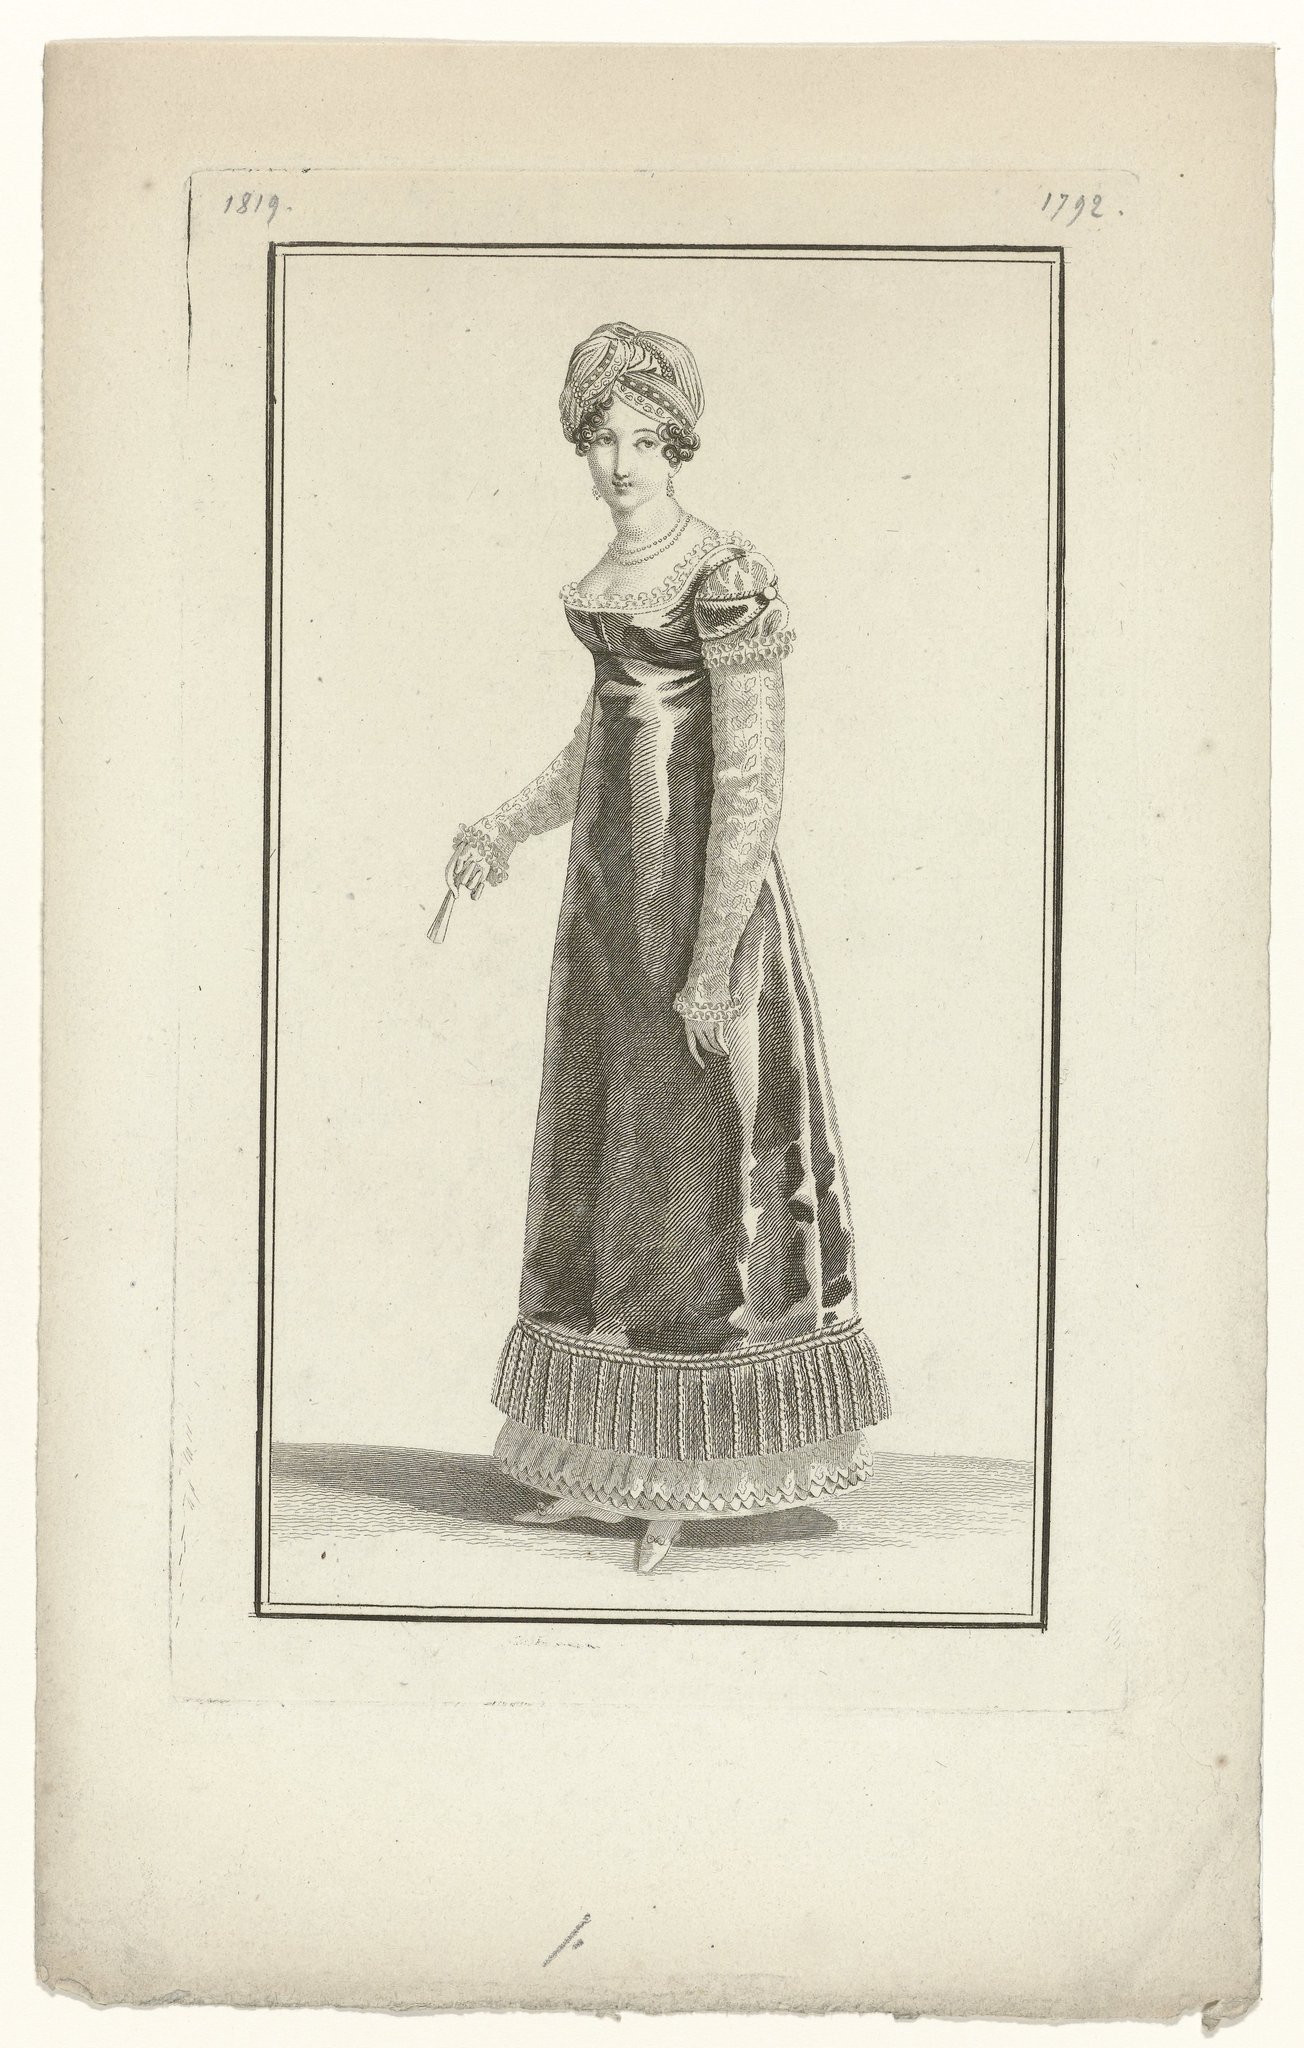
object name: fashion print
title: Journal des Dames et des Modes, Costume Parisien, 5 février 1819 (1792)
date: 1819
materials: paper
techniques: engraving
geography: paris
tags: ear-rings (+ women's clothes), head-gear: turban (+ women's clothes), dress, gown (pardessus) (+ women's clothes), fashion plates, shoes, sandals (+ women's clothes), dress, gown (+ women's clothes), fan (+ women's clothes), necklace (+ women's clothes)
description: Staande vrouw met op het hoofd een tulband van kasjmier met parels. Zij draagt een 'par-dessus' van effen fluweel, waaronder een japon van satijn met lange mouwen, gegarneerd met blonde (kloskant). Verdere accessoires: oorbellen, collier bestaande uit twee snoeren, waaier, platte schoenen met strikken. Proefdruk van een prent uit het modetijdschrift Journal des Dames et des Modes, uitgegeven door Pierre de la Mésangère, Parijs, 1797-1839.